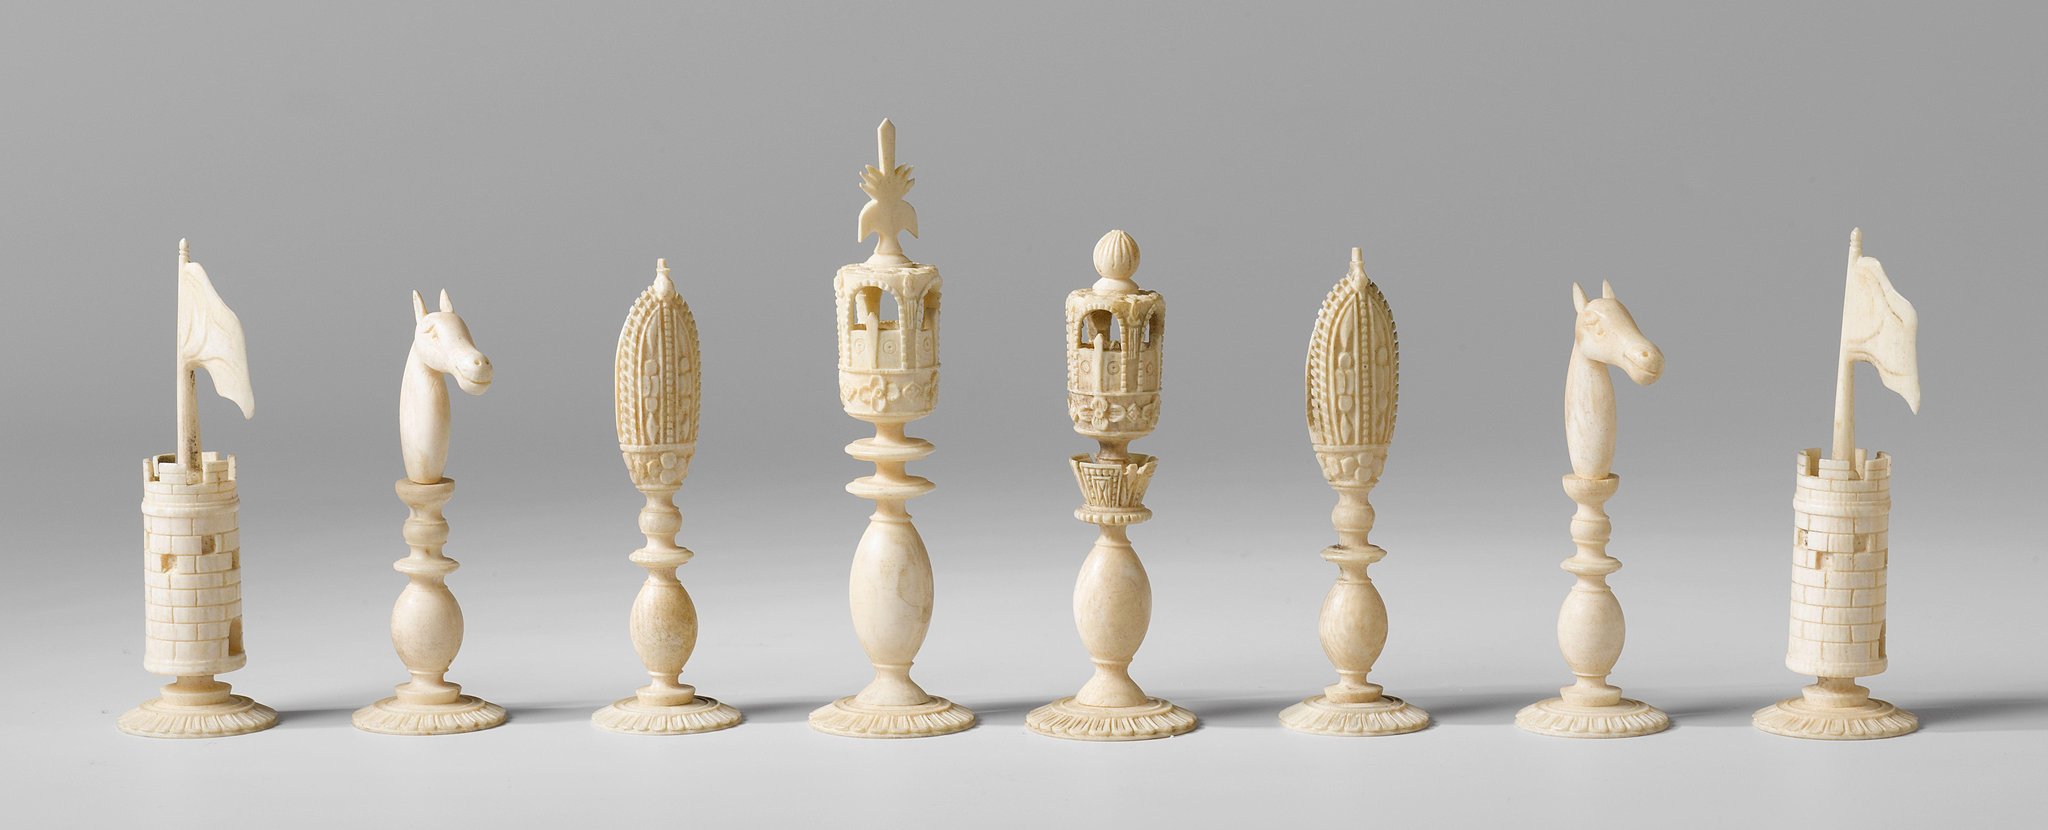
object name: chess piece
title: Schaakspel, witte stukken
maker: Anonymous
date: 1800-1850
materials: ivory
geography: guangdong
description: Eenvoudig schaakspel van ivoor. De stukken hebben een vaasvorm met een ronde, breed uitlopende voet, versierd met een palmettenrand. De koning en de koningin zijn vormgegeven als een soort paviljoens, de lopers als gestileerde bisschopsmijters, de torens worden verbeeld door torens met vlaggen en de paarden door paardenhoofden. De pionnen hebben een vaasvorm met een vlam.